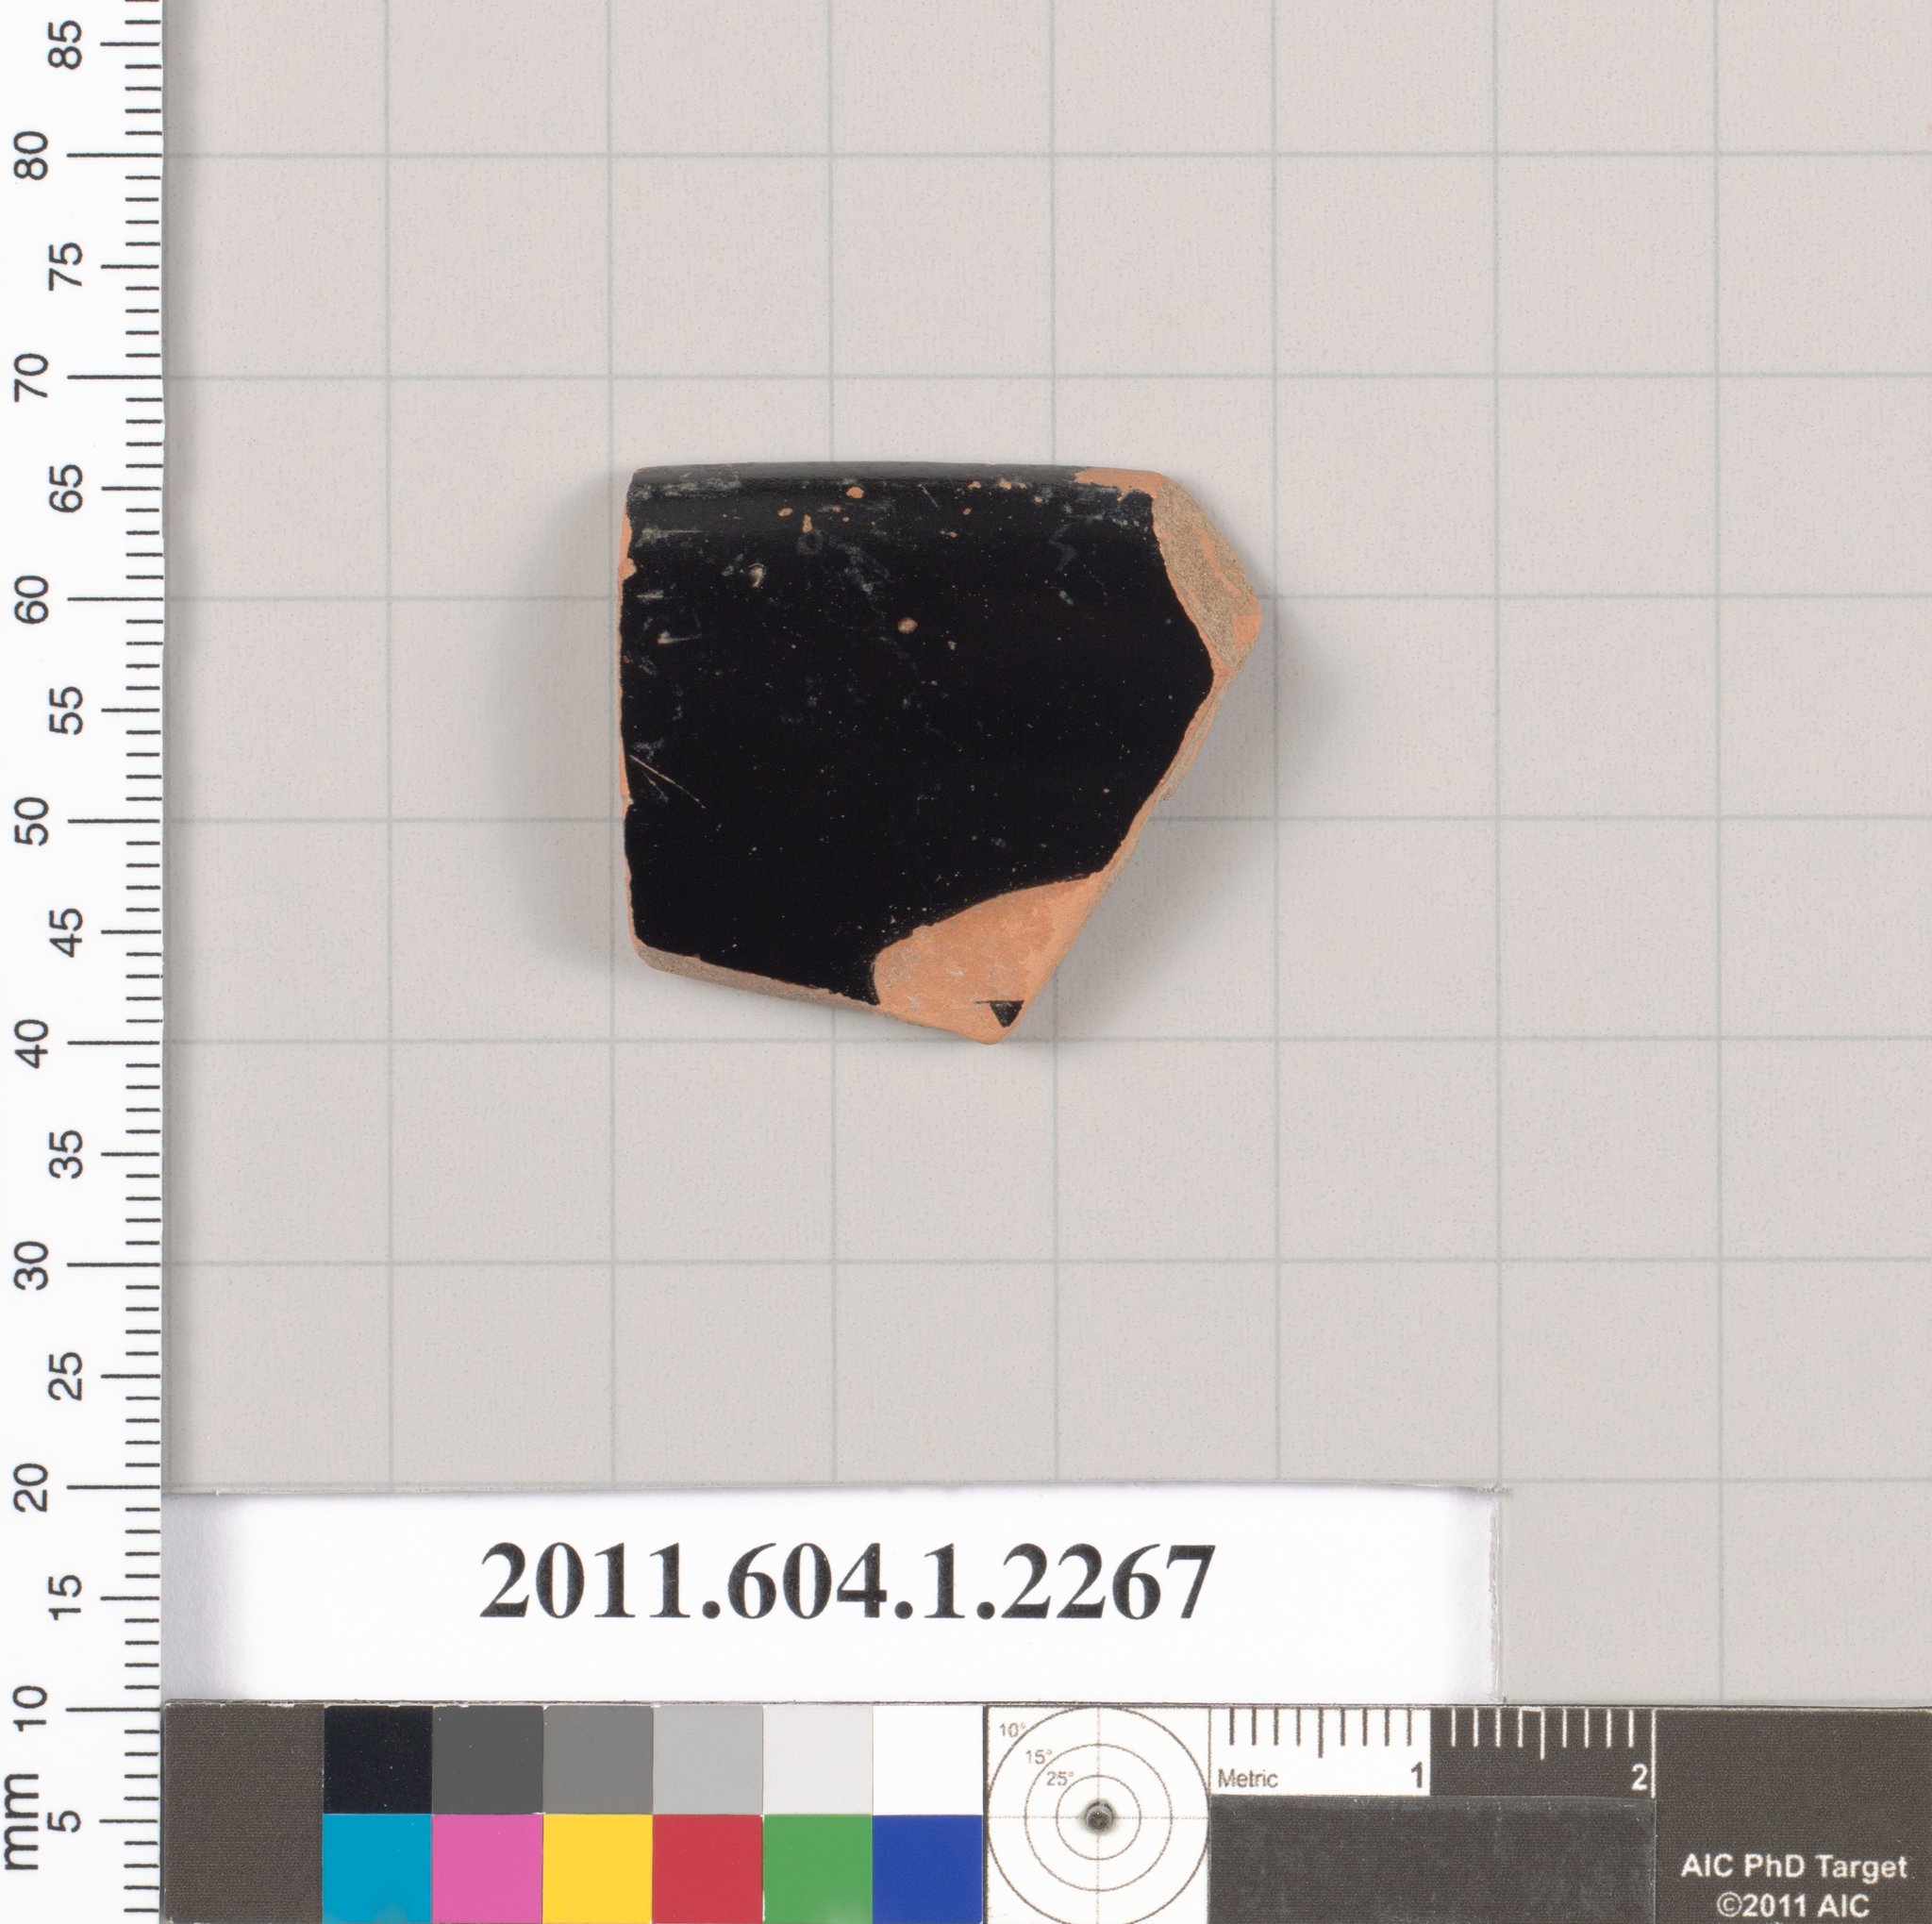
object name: kylix fragment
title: Terracotta rim fragment of a kylix (drinking cup)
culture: greek, attic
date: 475-451 BCE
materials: terracotta